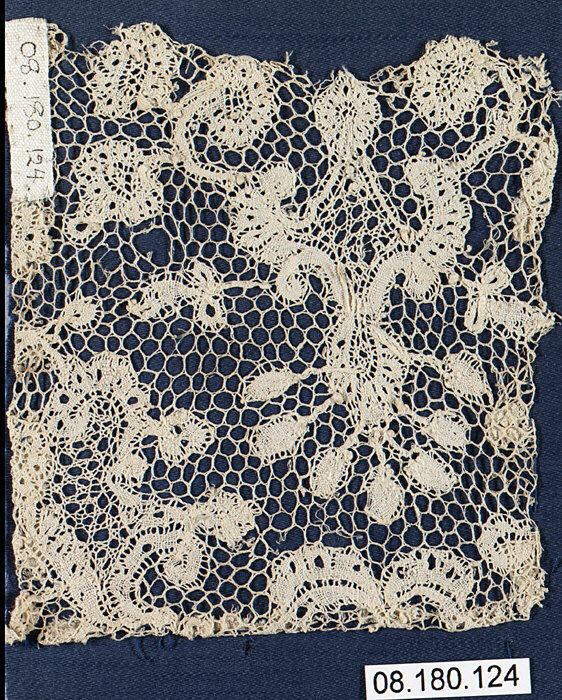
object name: fragment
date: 1701-1800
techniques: lace